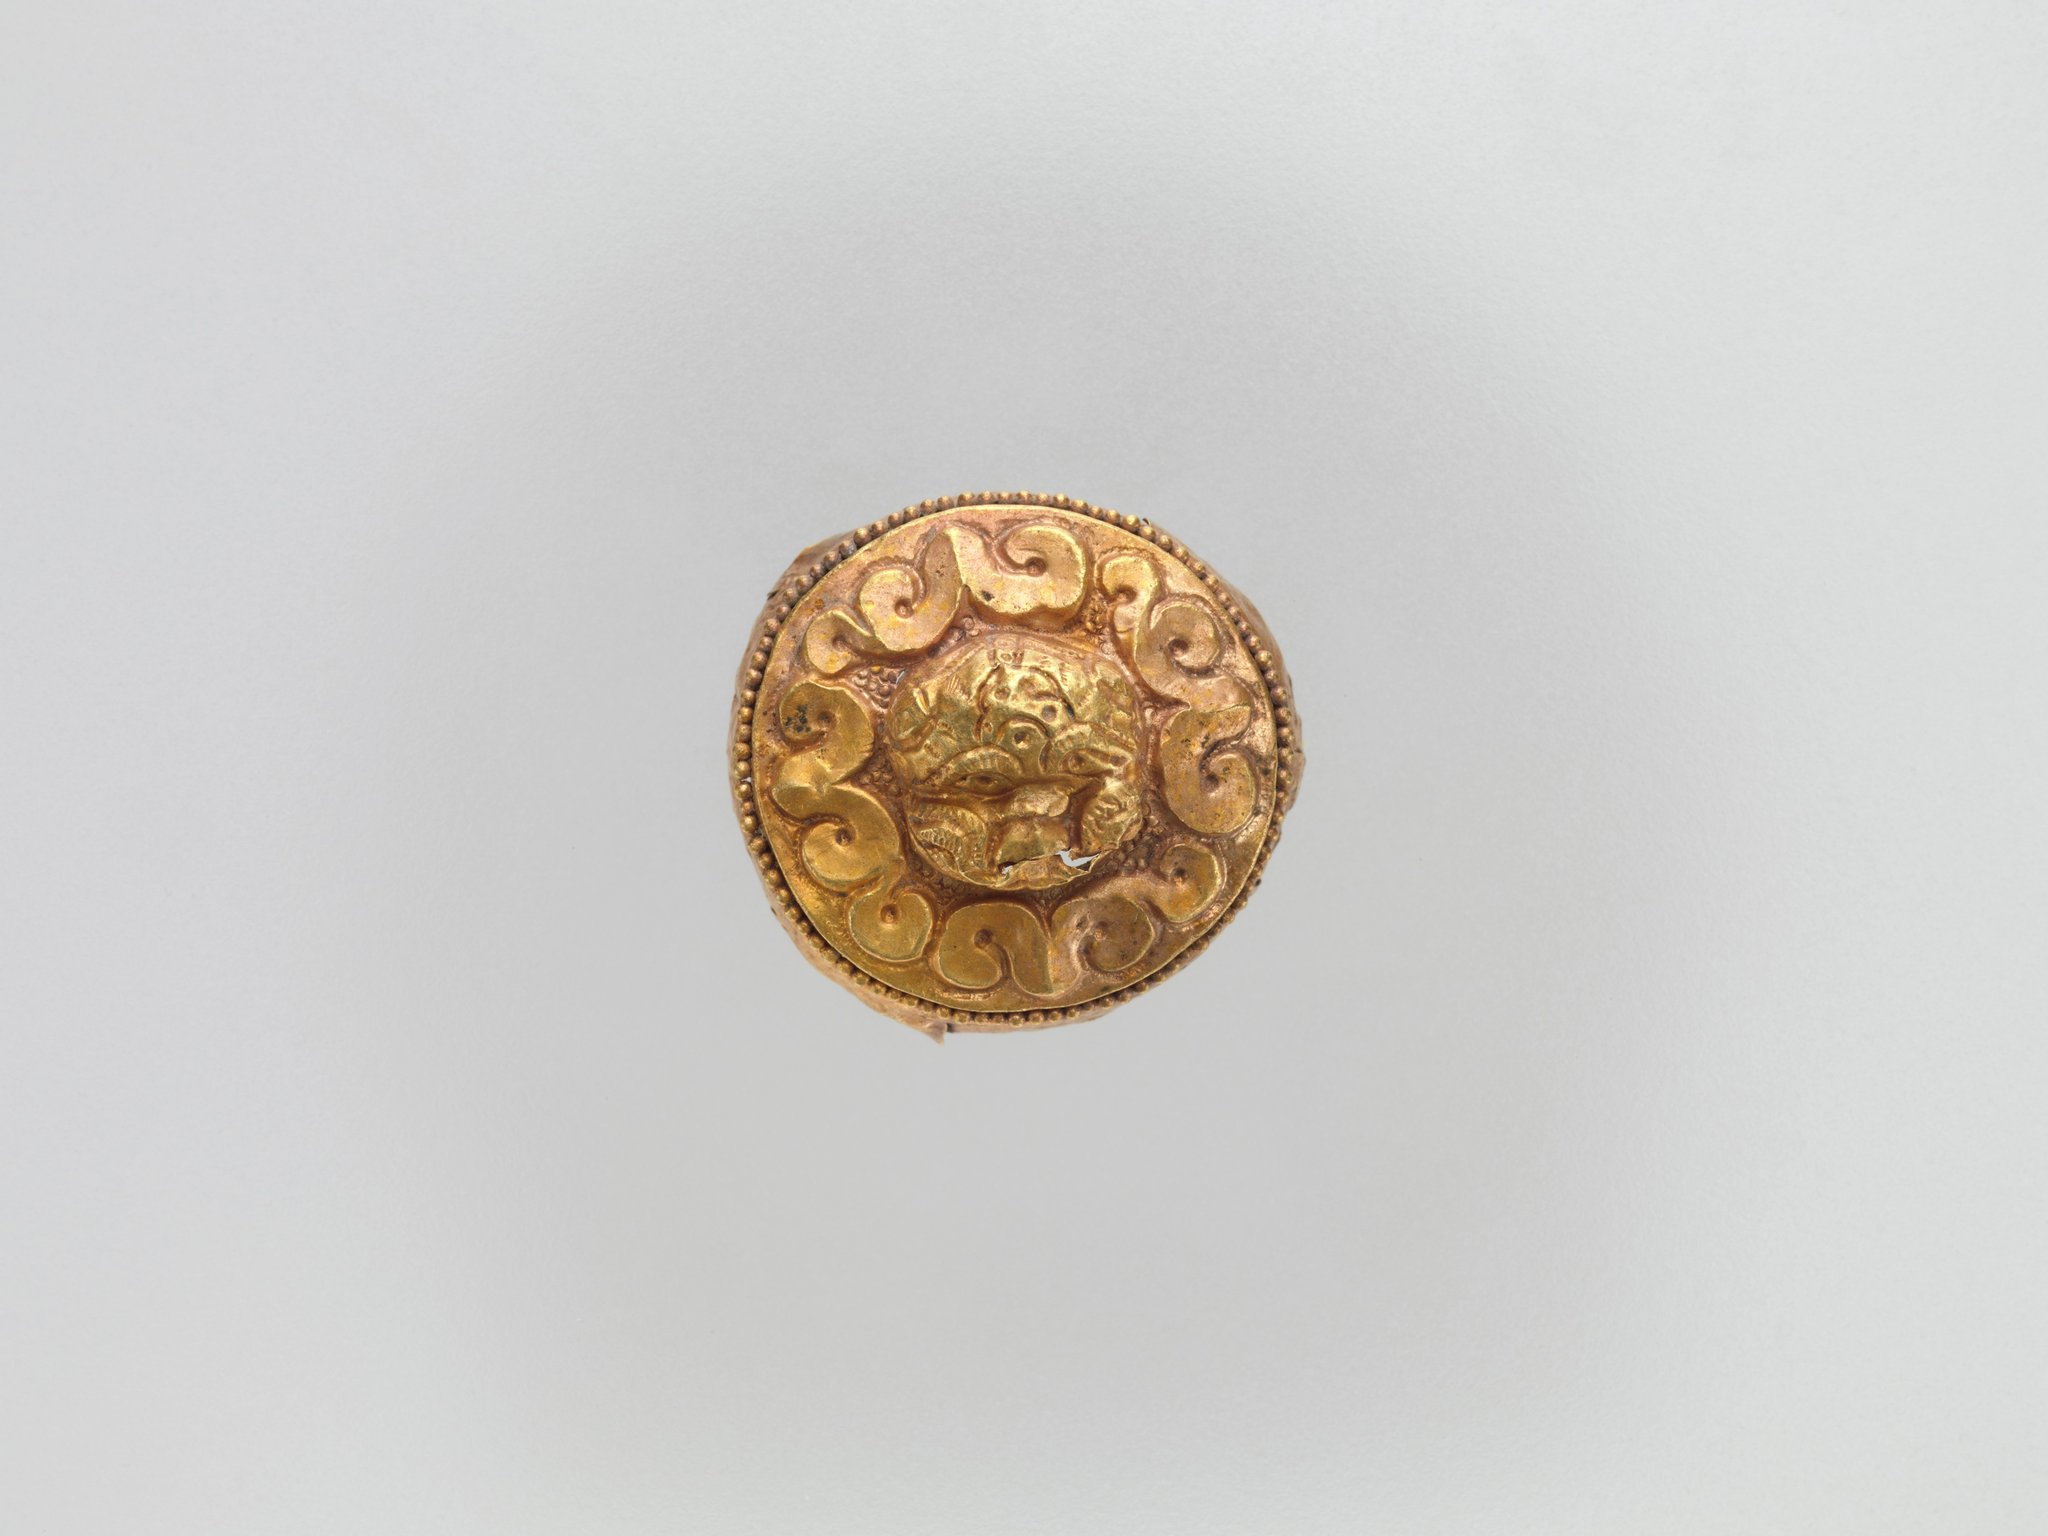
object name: plaque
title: Cap-Shaped Plaque with Lion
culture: chinese or central asian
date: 601-900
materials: gold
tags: lions